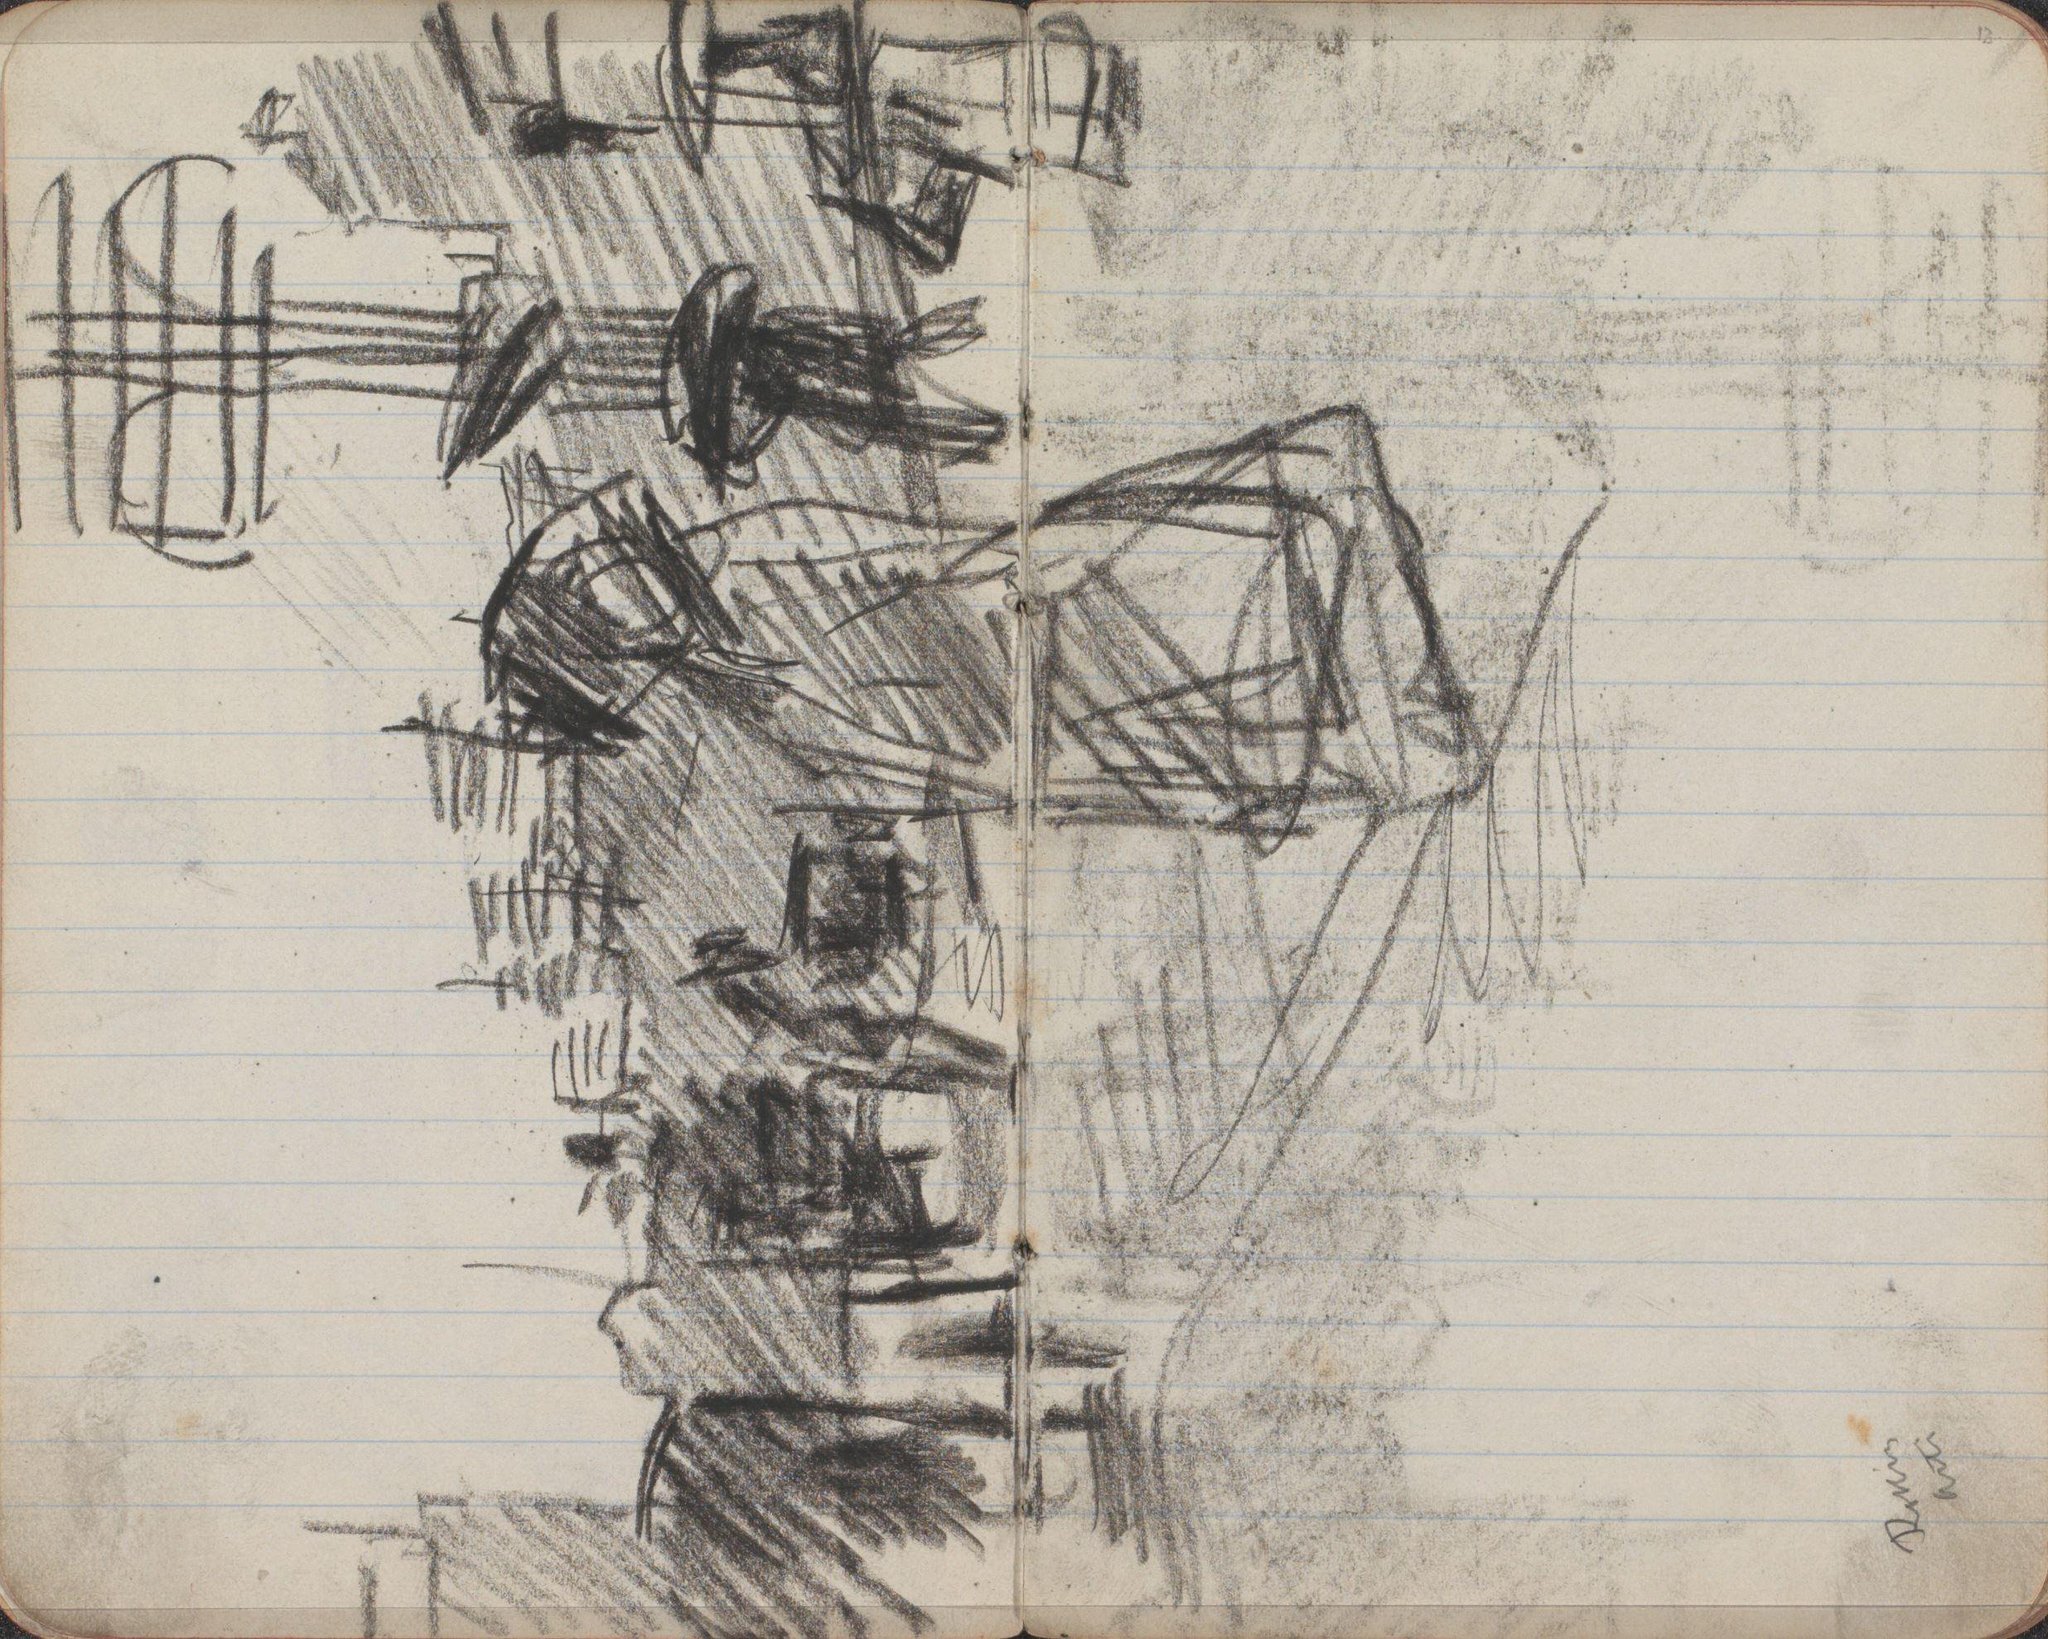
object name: sketchbook leaf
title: Figuren met paraplu's op het Rokin te Amsterdam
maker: george hendrik breitner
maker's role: draughtsman, painter, print maker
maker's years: 1857-1923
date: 1890-1900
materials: chalk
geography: amsterdam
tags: rain, civic architecture; edifices; dwellings, street (+ city(-scape) with figures, staffage)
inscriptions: annotation: ‘Rokin/ Arti’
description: Gezien vanuit Rokin 112, kunstenaarsvereniging Arti et Amicitiae. Pagina 11 en pagina 12 uit een schetsboek met 33 bladen.